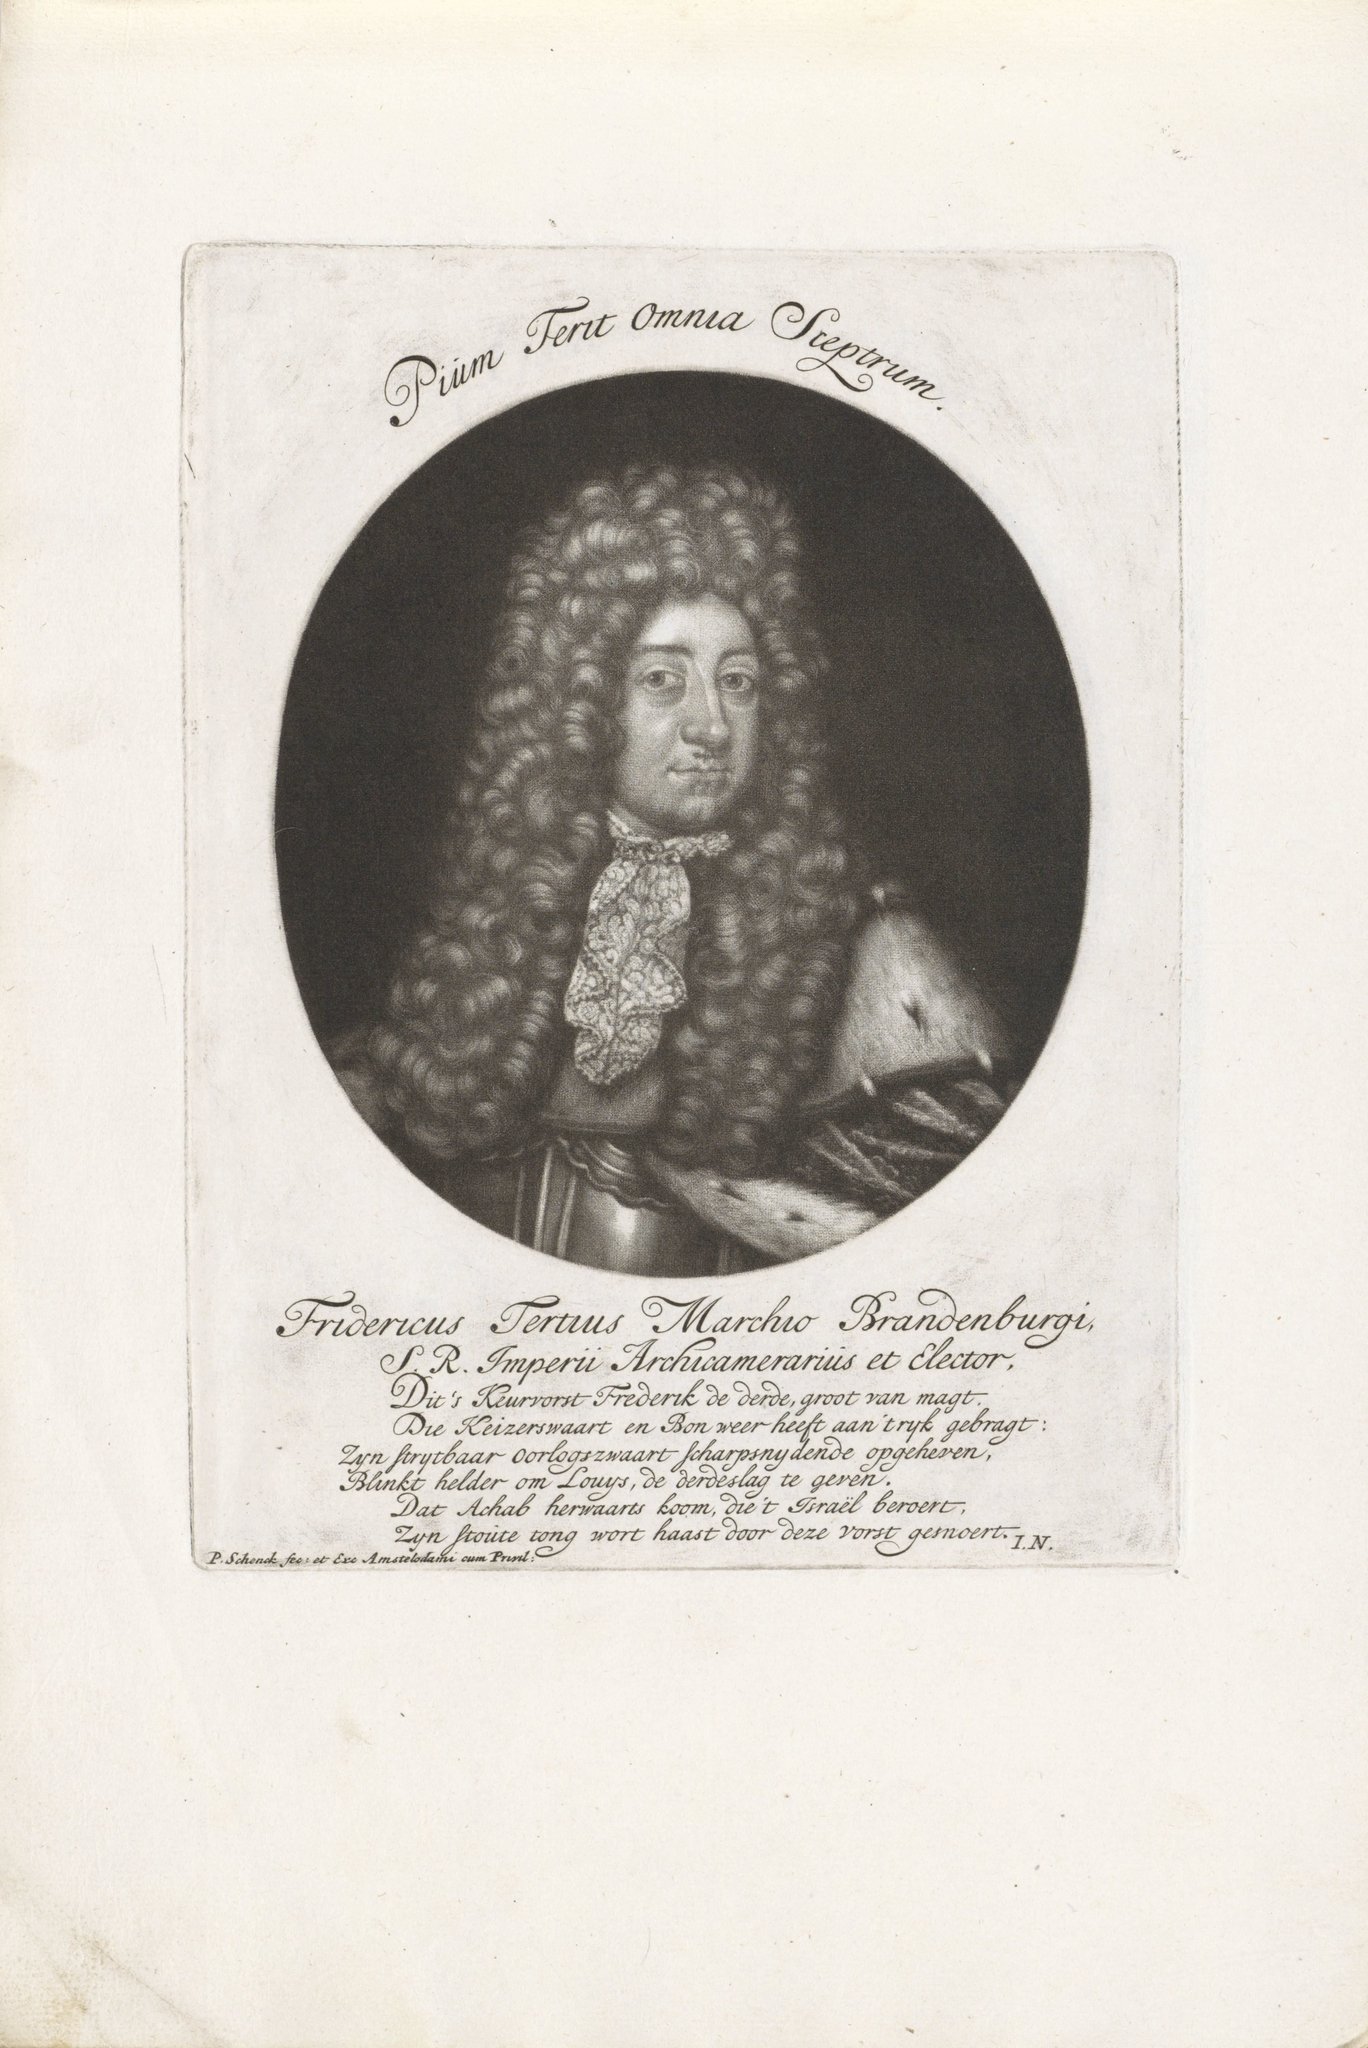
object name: print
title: Leopoldo I Magno S.R.I. Imperatori Semper Augusto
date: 1690-1713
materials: paper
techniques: engraving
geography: amsterdam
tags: berlin, frederik i koning van pruisen, harness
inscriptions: collector's mark: Lugt 2228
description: Frederik I, koning in Pruisen en als Frederik III, keurvorst van Brandenburg. Hij was van 1688 tot 1701 keurvorst van Brandenburg en tot zijn dood Frederik I koning van Pruisen.